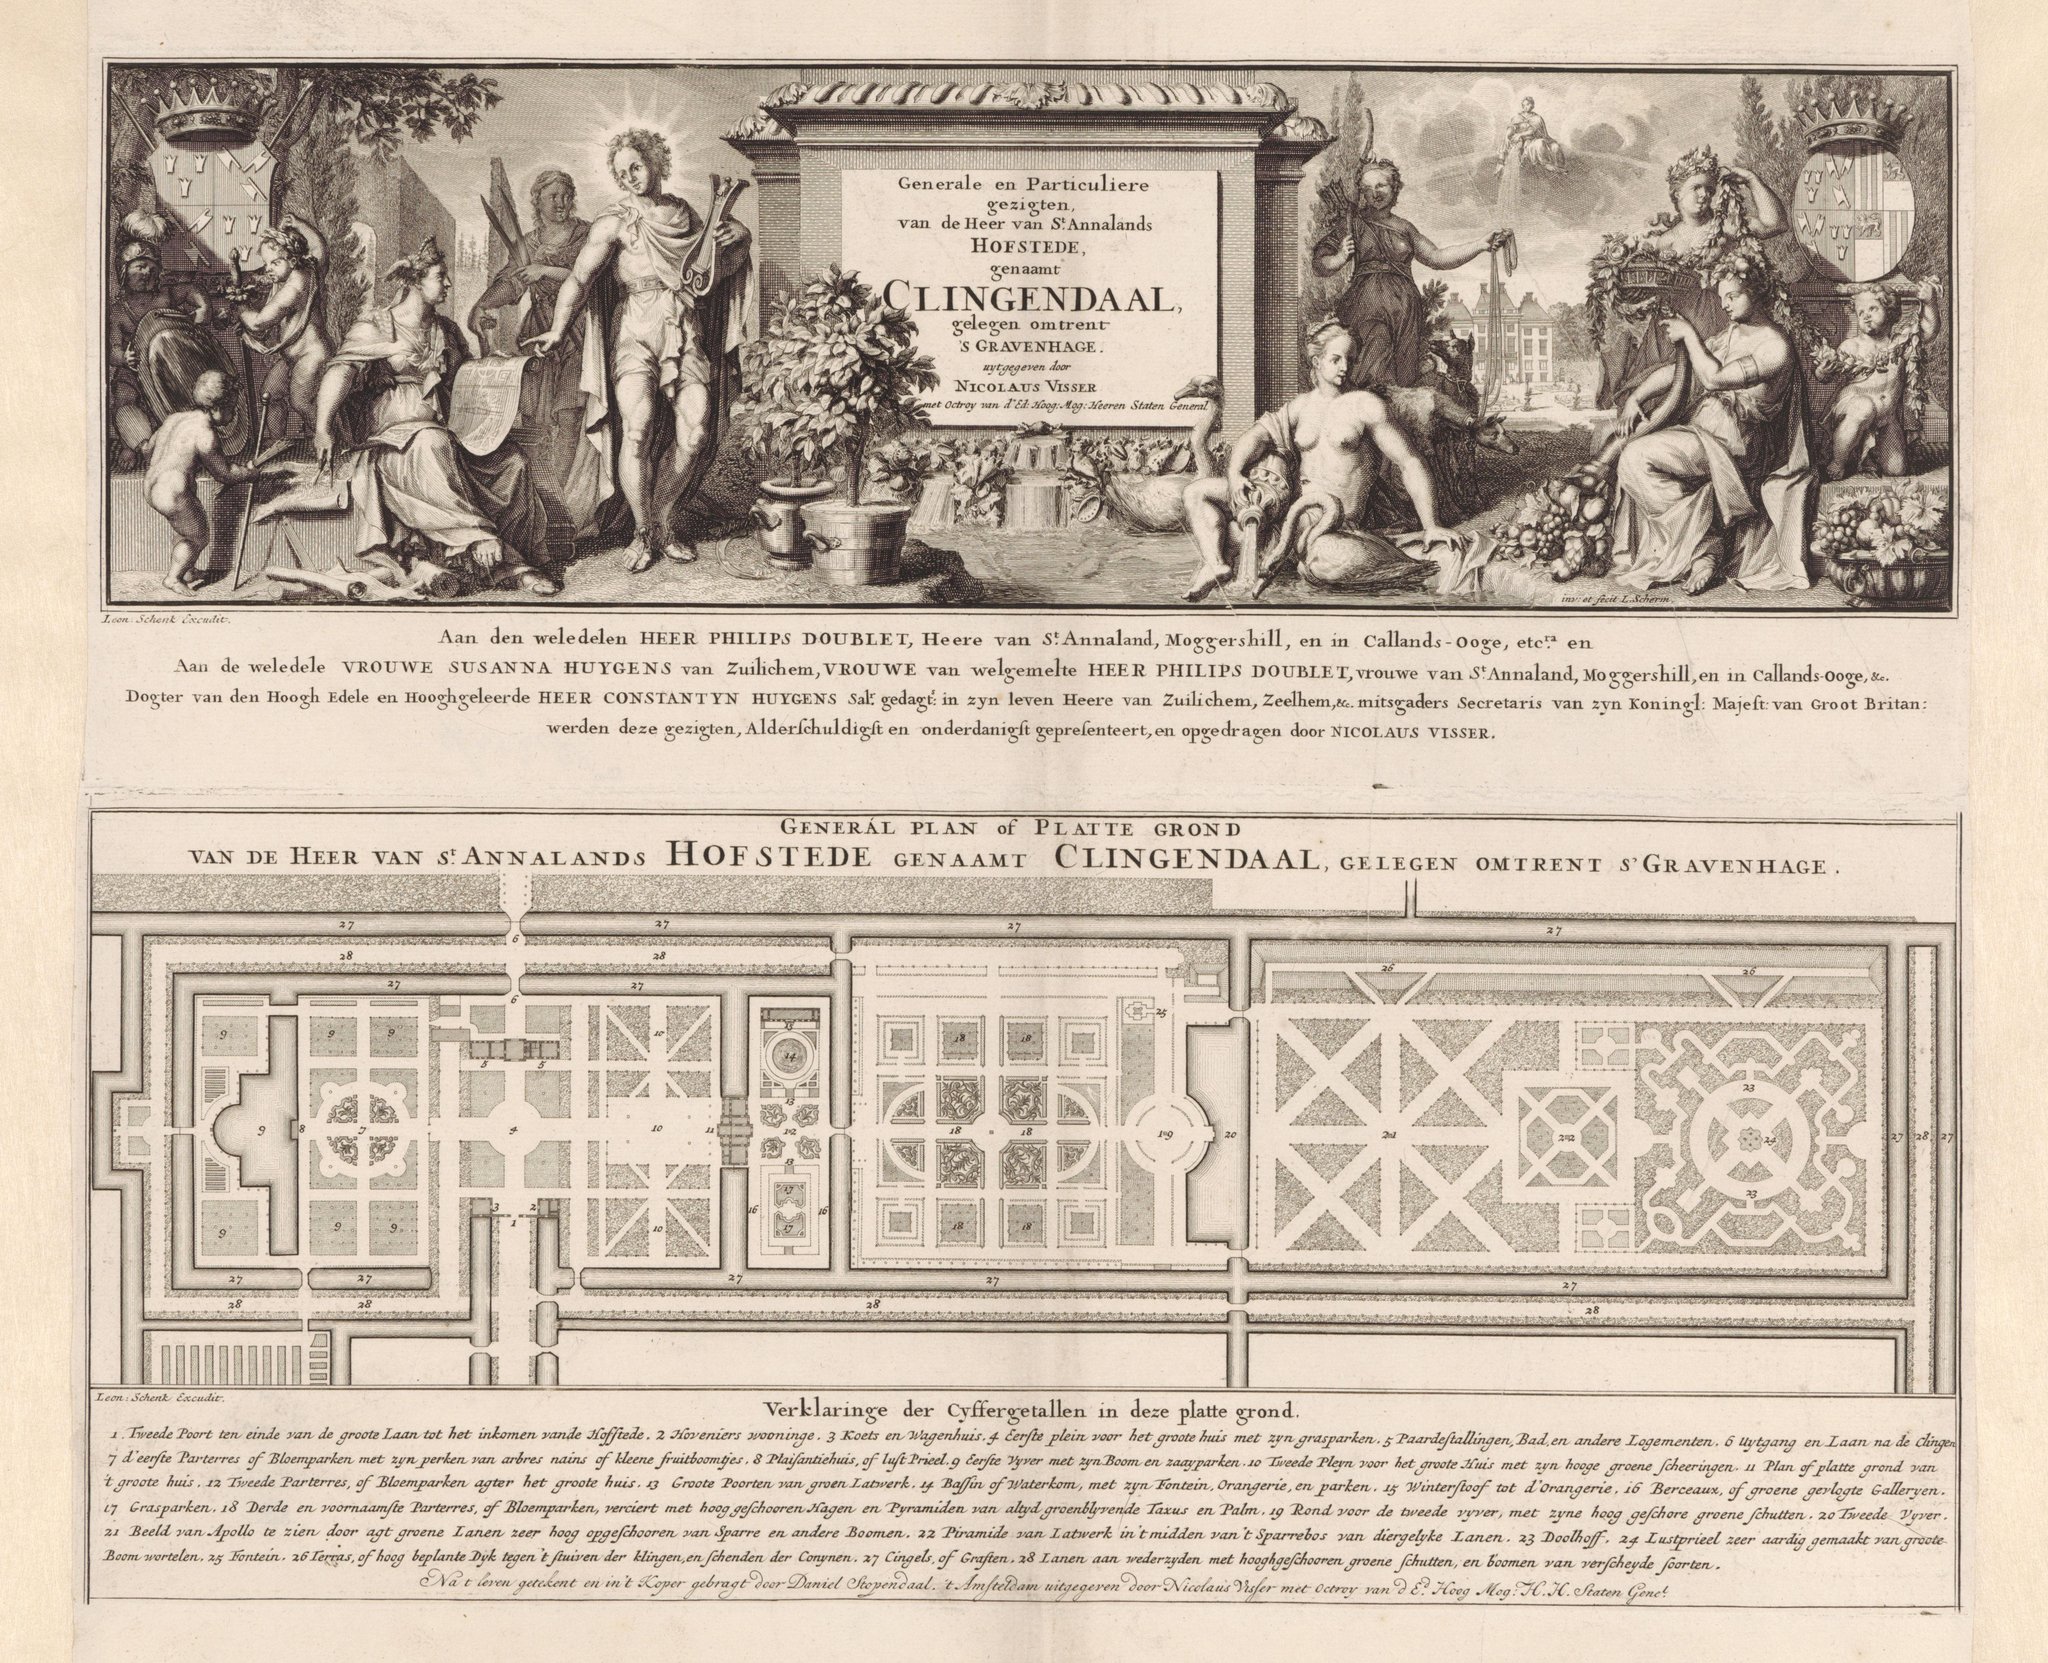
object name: titelprent, frontispice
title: General Plan of Platte Grond van de Heer van St. Annalands Hofstede genaamt Clingendaal, gelegen omtrent s' Gravenhage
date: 1660-1701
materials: paper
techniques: engraving, etching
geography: amsterdam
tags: the hague, susanna huygens, philips doublet (ii), 'cornucopia', horn of plenty, (story of) diana (artemis), (story of) apollo (phoebus), abundance; 'abondanza', 'abondanza maritima' (ripa) (+ personification), french or architectonic garden; formal garden, 'architectura', symbolic representations, allegories and emblems ~ architecture; 'architettura' (ripa), plan ~ architecture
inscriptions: collector's mark: Lugt 2228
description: Twee voorstellingen op een blad. Boven: Links van het monument met de serietitel staat Apollo als de patroon van de kunsten. Hij geeft opdracht aan Architectuur. Zij houdt plattegronden in haar hand en een passer in de andere hand. Geheel links spelen putti onder het wapenschild van de eigenaar van het landgoed: Philips Doublet (II). Rechts staat Diana als patrones van de jacht met haar boog en jachthonden. Geheel rechts Flora, met een bloemenmand, en Overvloed met een hoorn des overvloeds. Zij staan bij het wapenschild van Susanna Huygens, de vrouw van Philips Doublet. Onder: Plattegrond van landgoed Clingendael bij Den Haag. Onderaan een legenda 1-28 in het Nederlands.